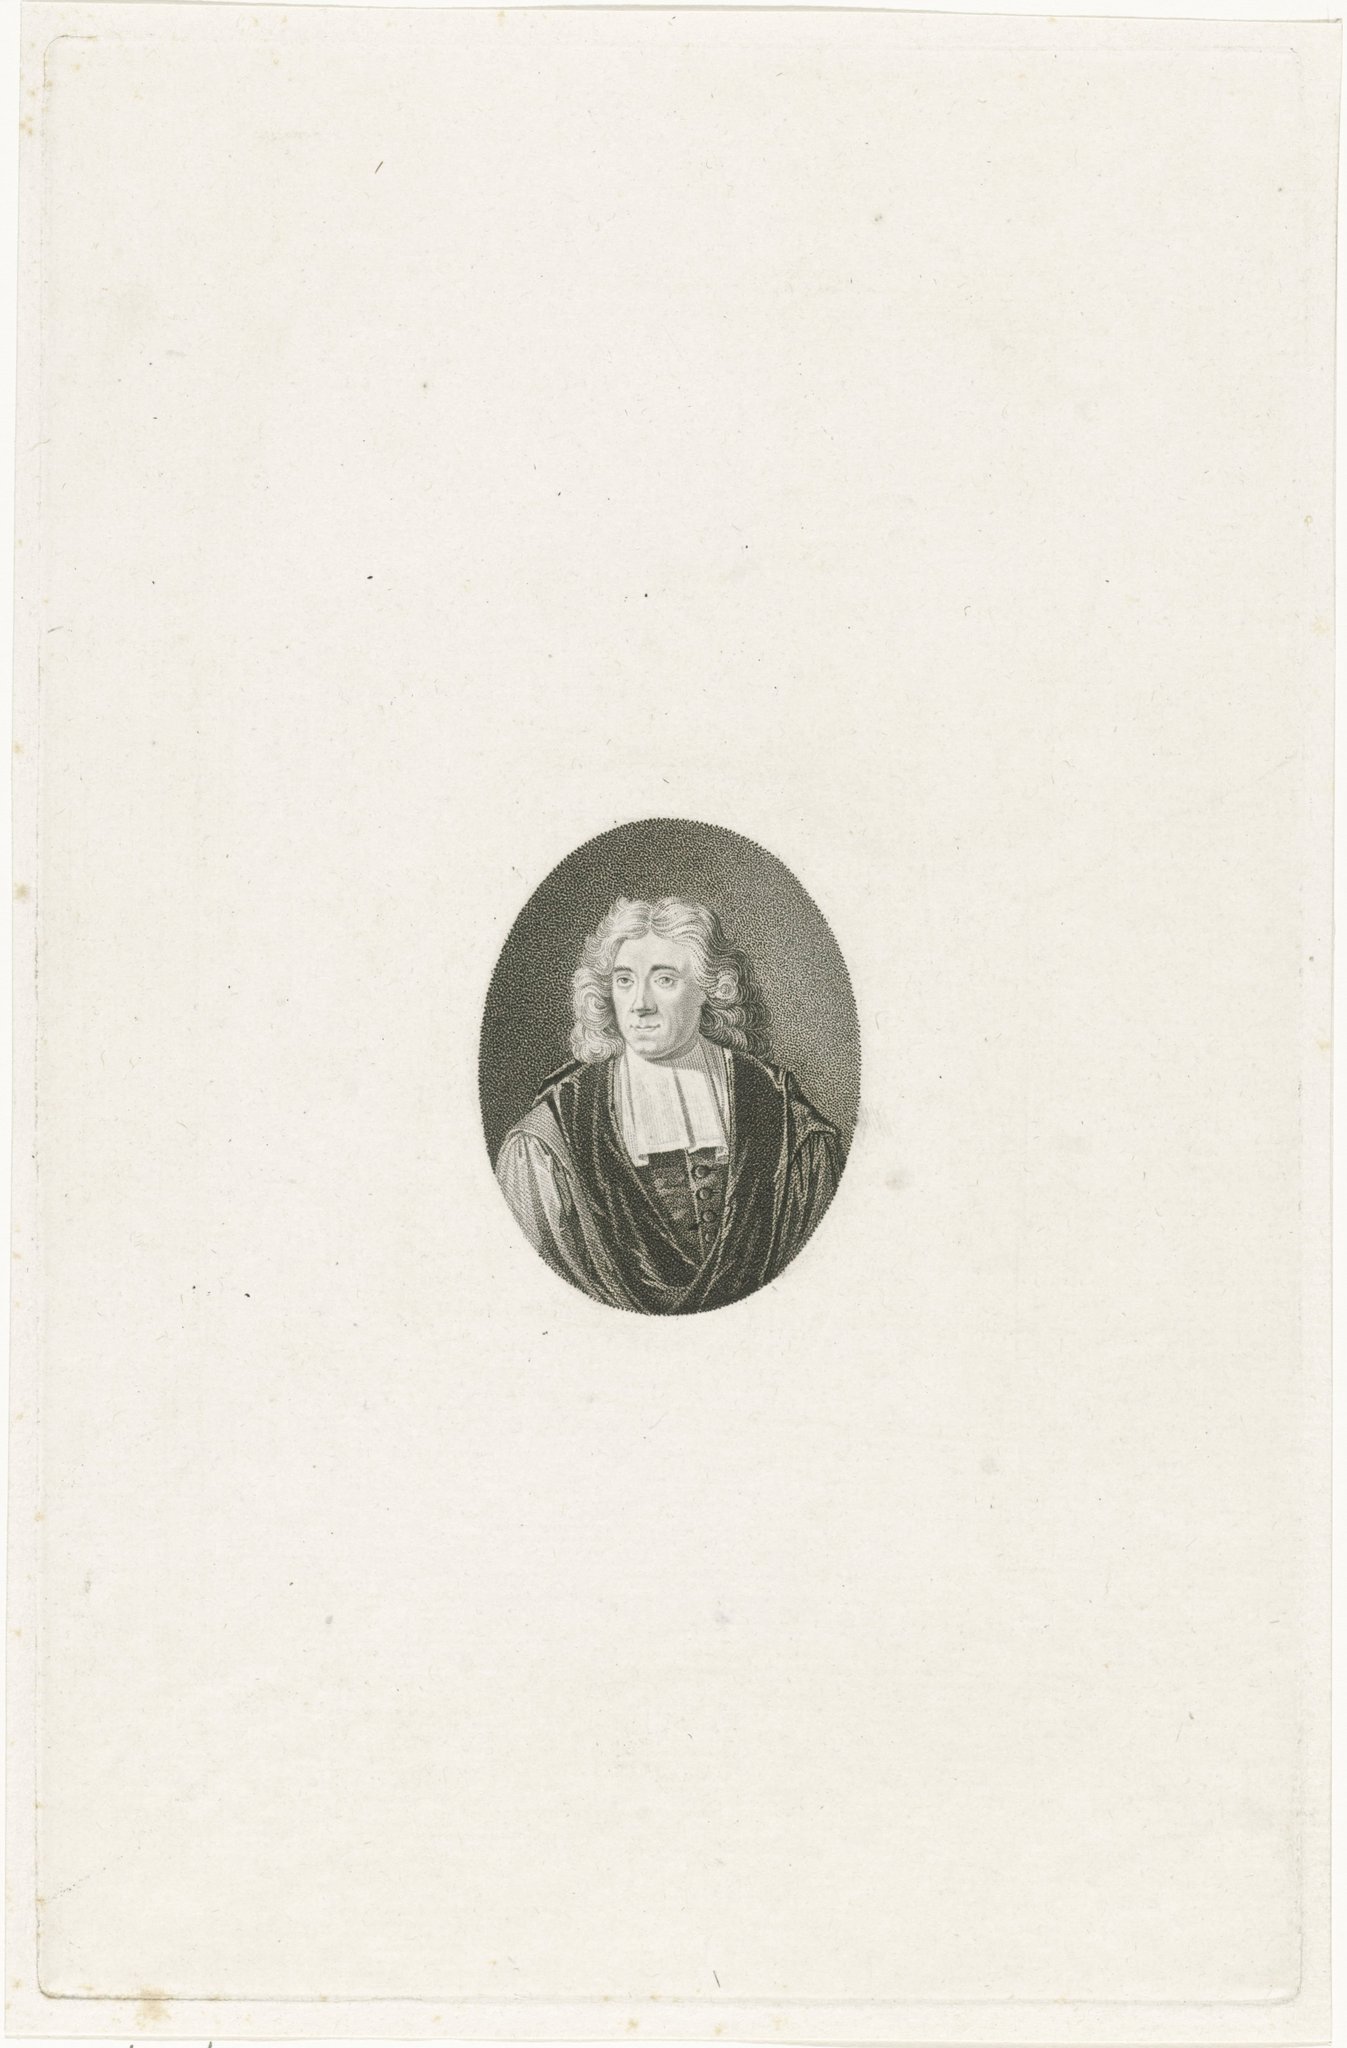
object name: print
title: Portret van Adriaan Reland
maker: pieter van der meulen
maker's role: draughtsman, painter, print maker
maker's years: 1780-1858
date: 1790-1853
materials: paper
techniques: etching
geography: amsterdam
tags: utrecht, adriaan reeland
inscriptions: collector's mark: Lugt 2228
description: Portret van de schrijver Adriaan Reland.